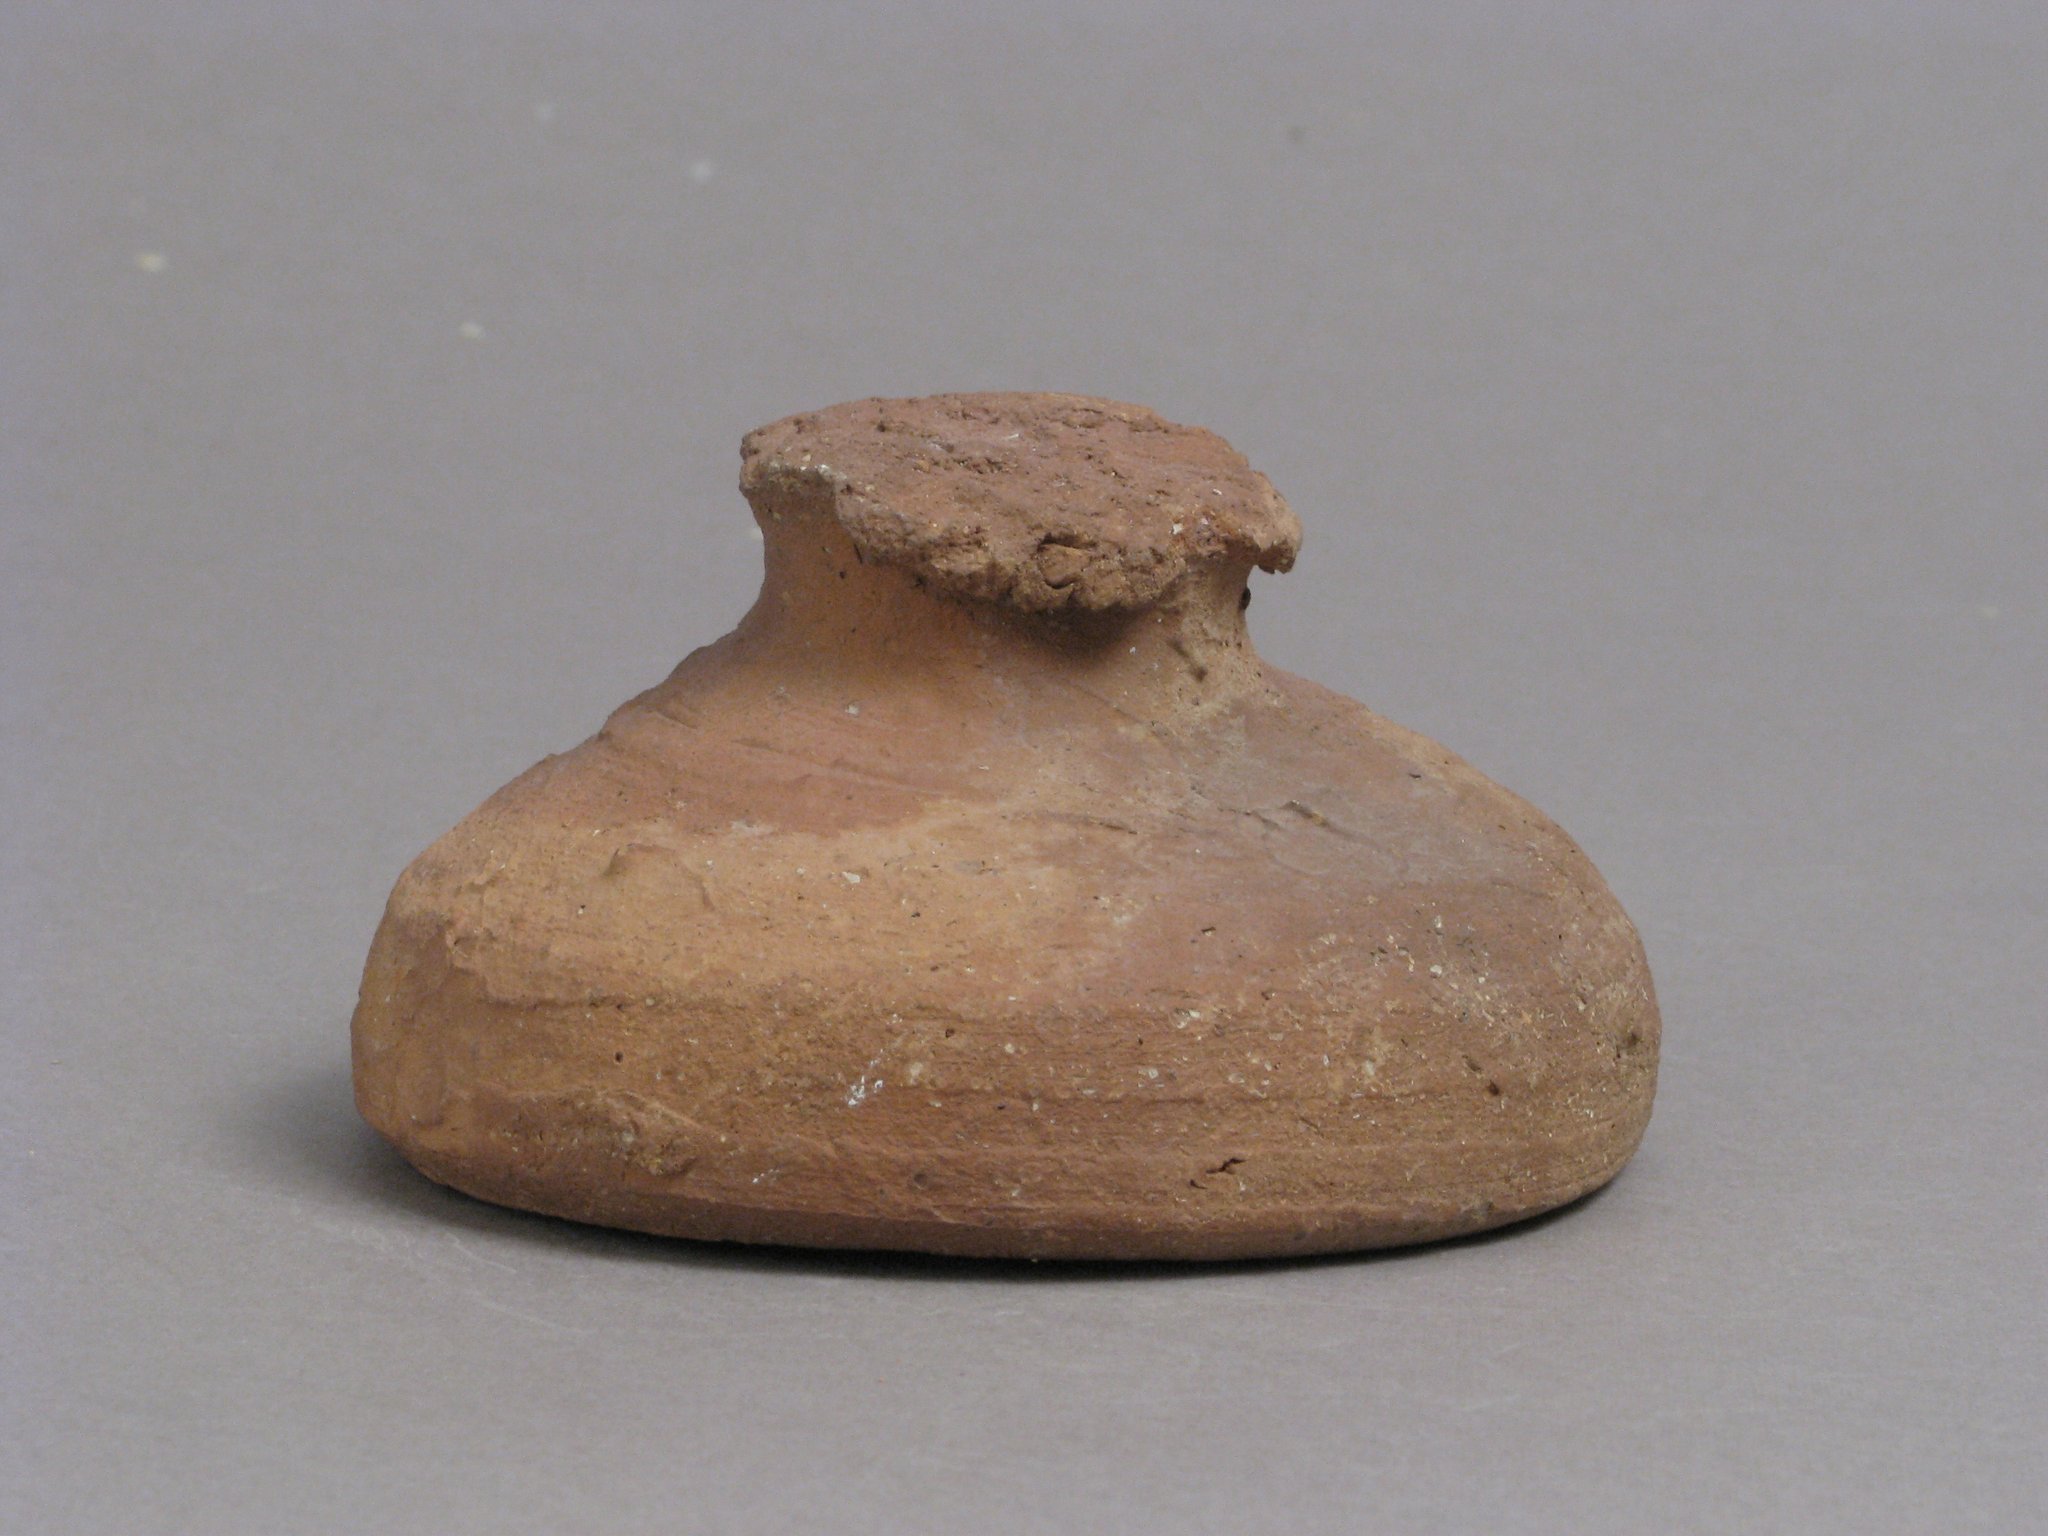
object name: lid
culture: coptic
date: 301-700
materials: earthenware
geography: egypt